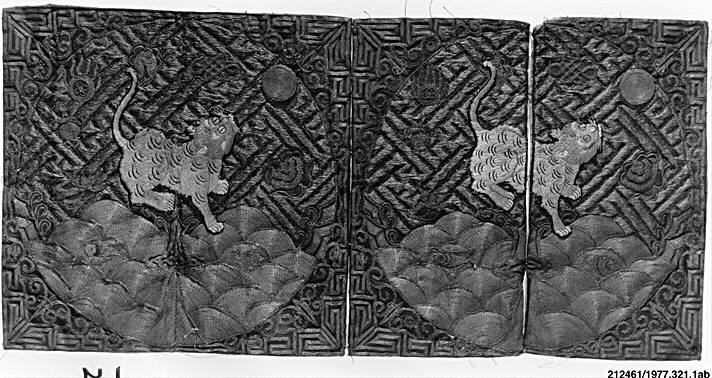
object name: rank badge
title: Rank Badge with Tiger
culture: chinese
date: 1867-1900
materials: gold, silk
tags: tigers